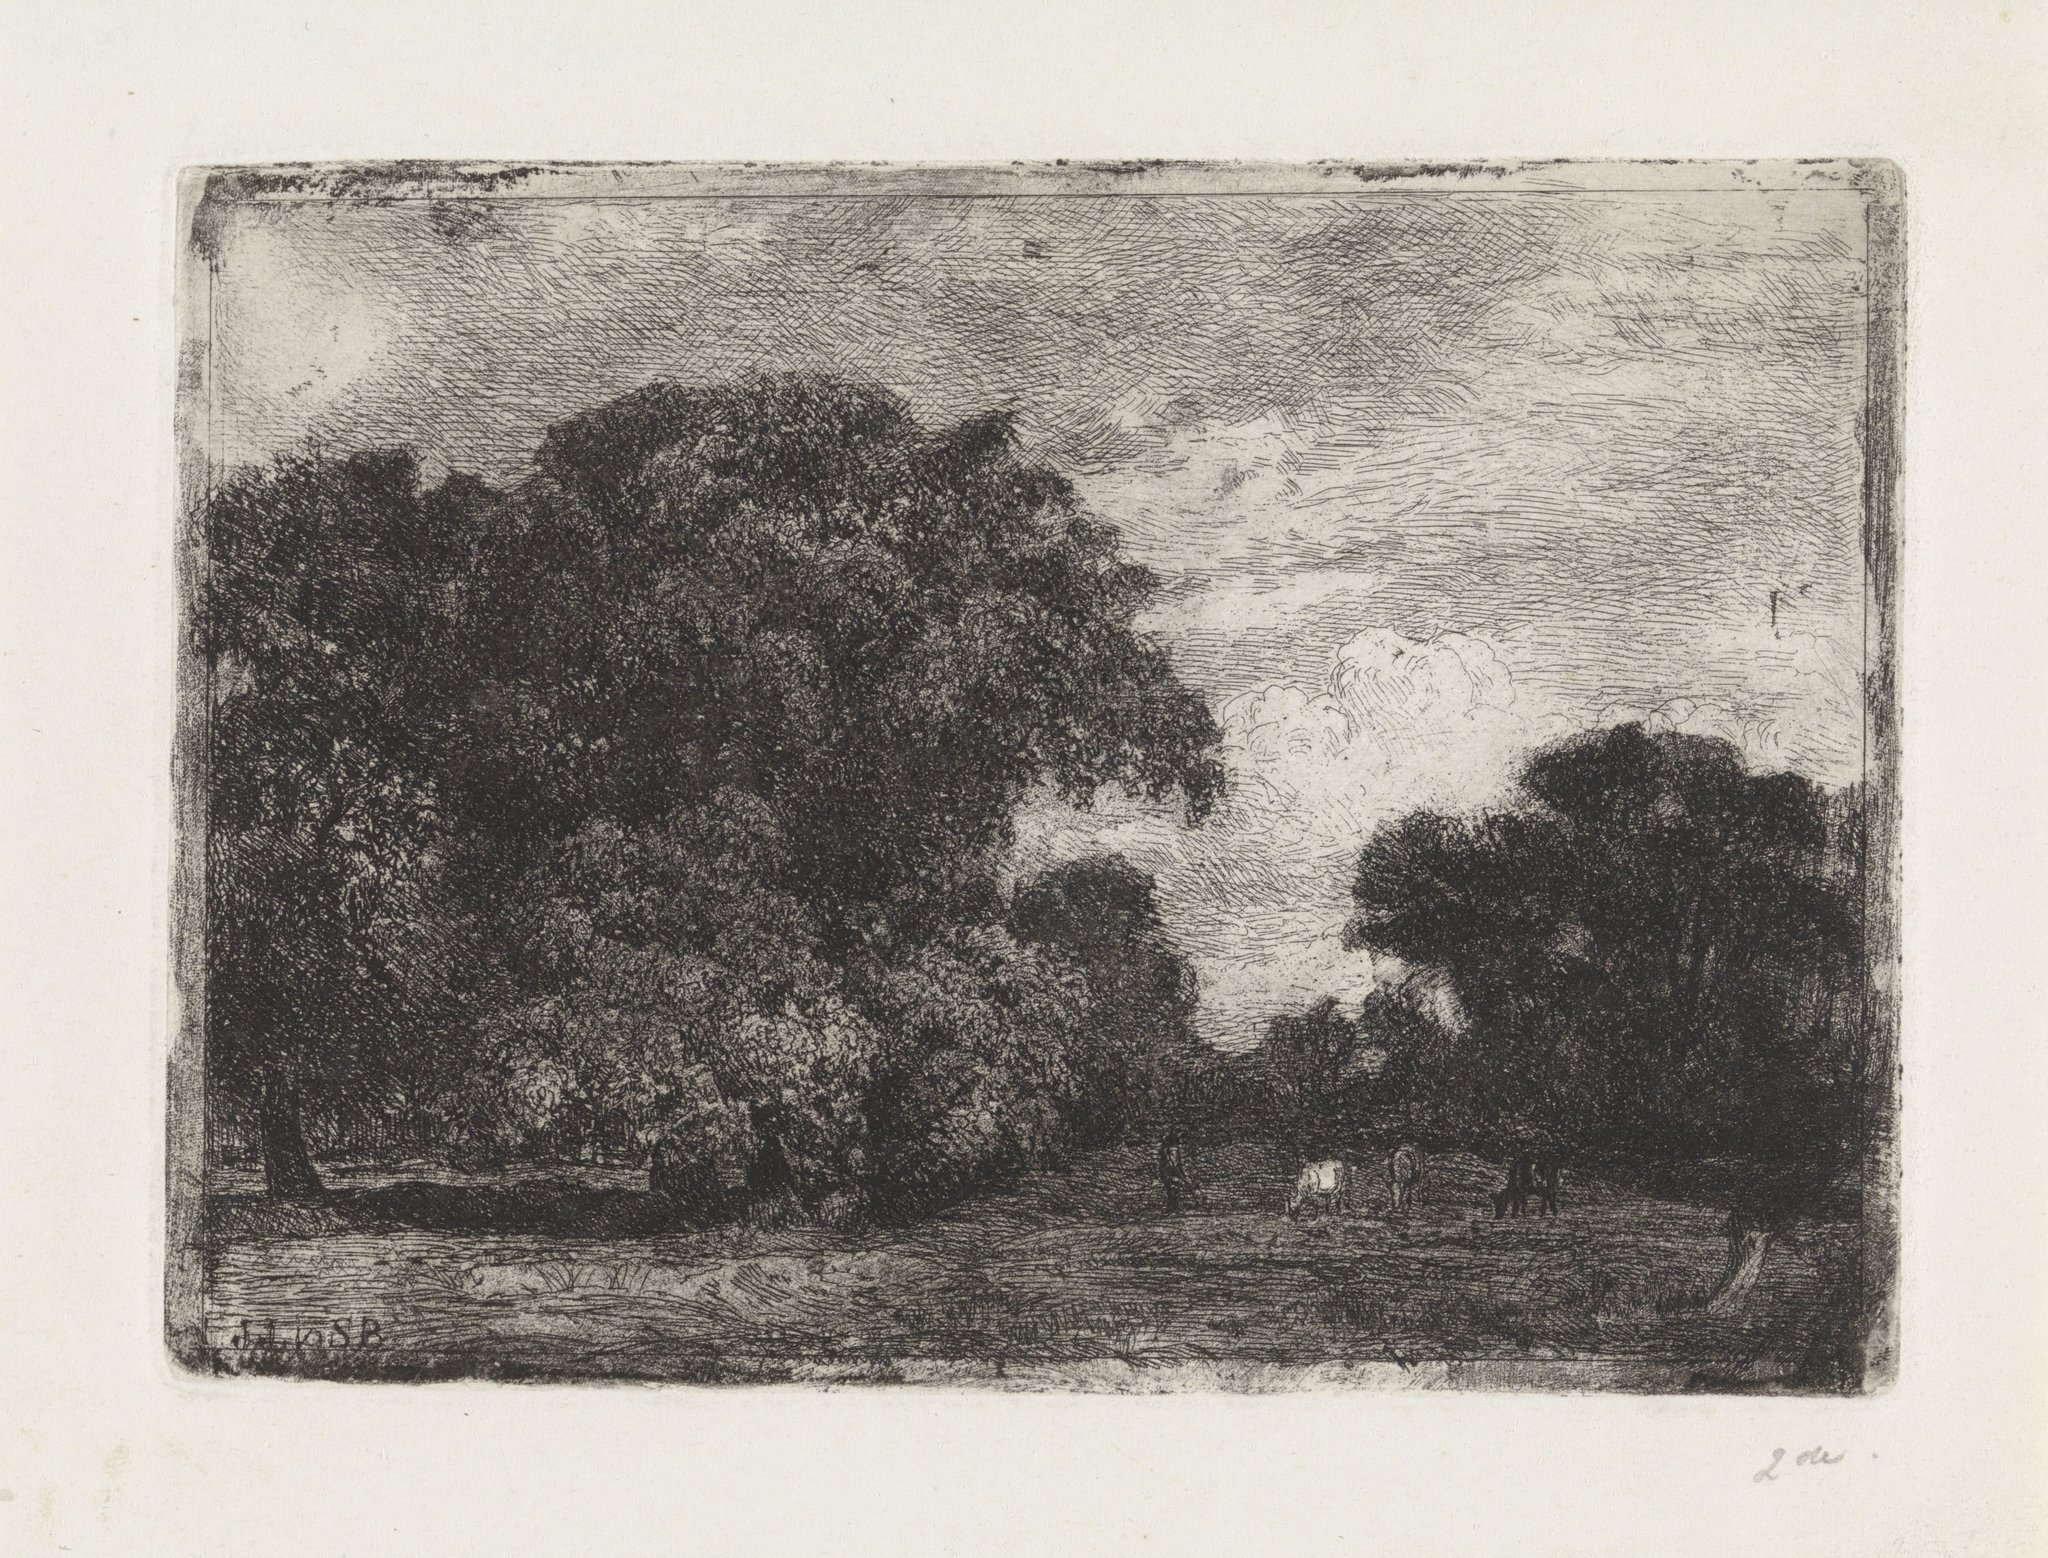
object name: print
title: Landschap met bomen en drie grazende koeien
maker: julius jacobus van de sande bakhuyzen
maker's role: draughtsman, painter, print maker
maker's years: 1835-1925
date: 1845-1892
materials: paper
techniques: drypoint, etching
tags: angels fighting, landscapes in the temperate zone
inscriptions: collector's mark: Lugt 2228